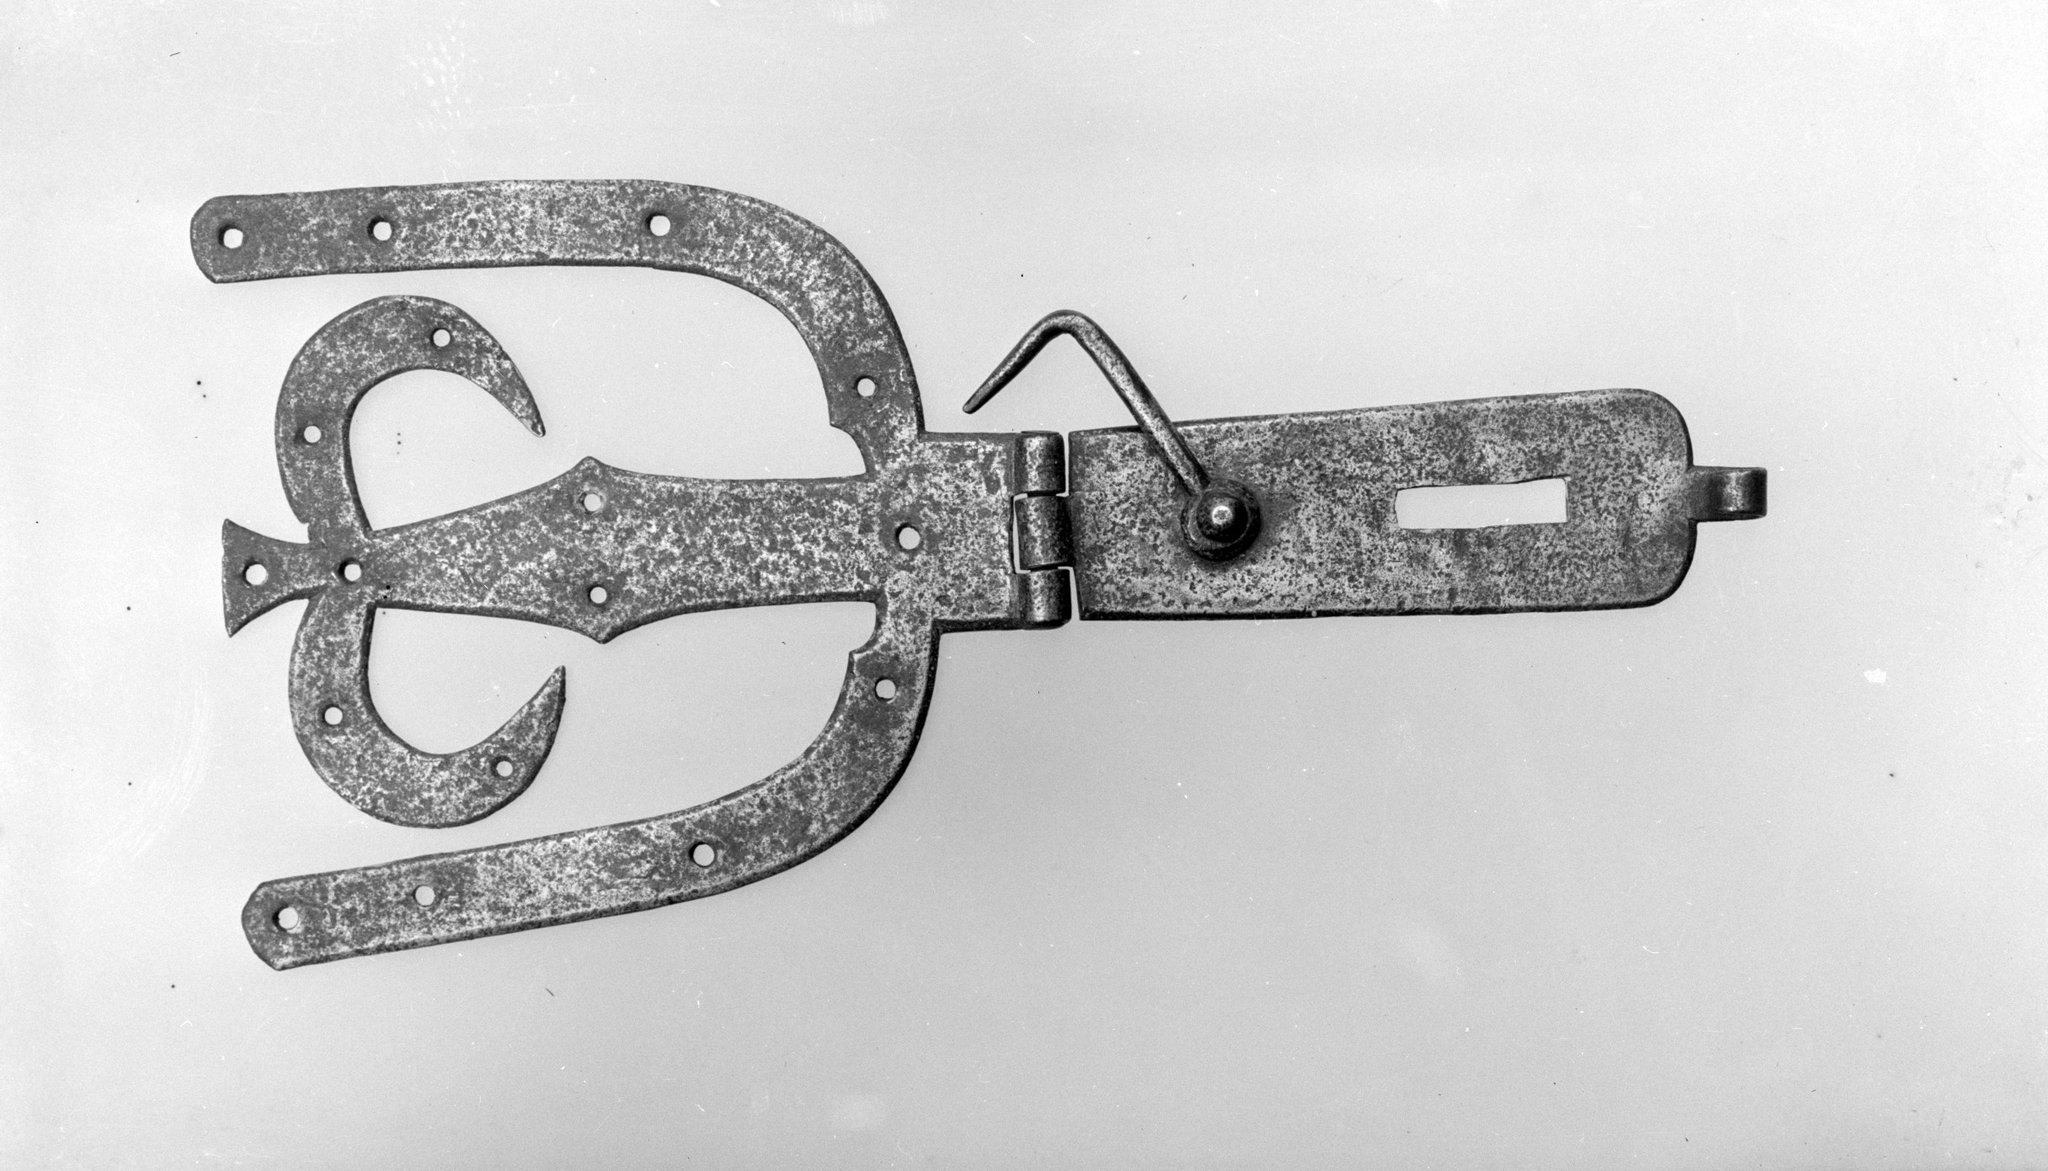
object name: hasp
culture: american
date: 1770-1830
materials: iron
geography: united states